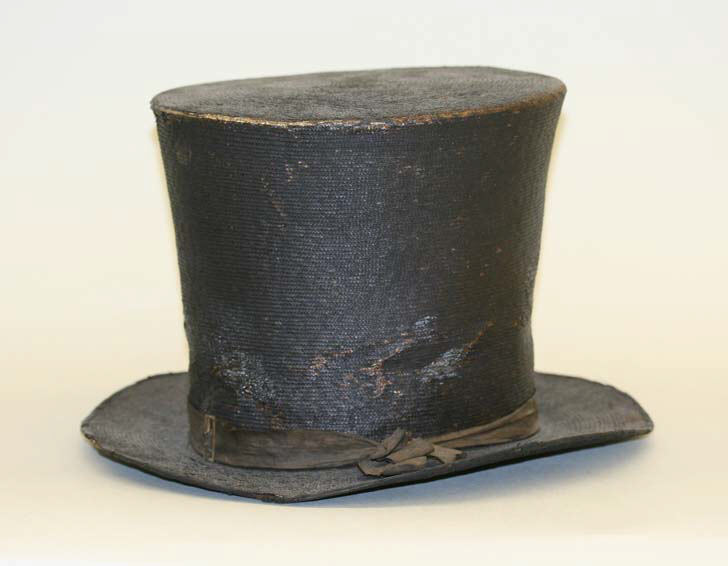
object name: hat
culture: american or european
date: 1805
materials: fiber